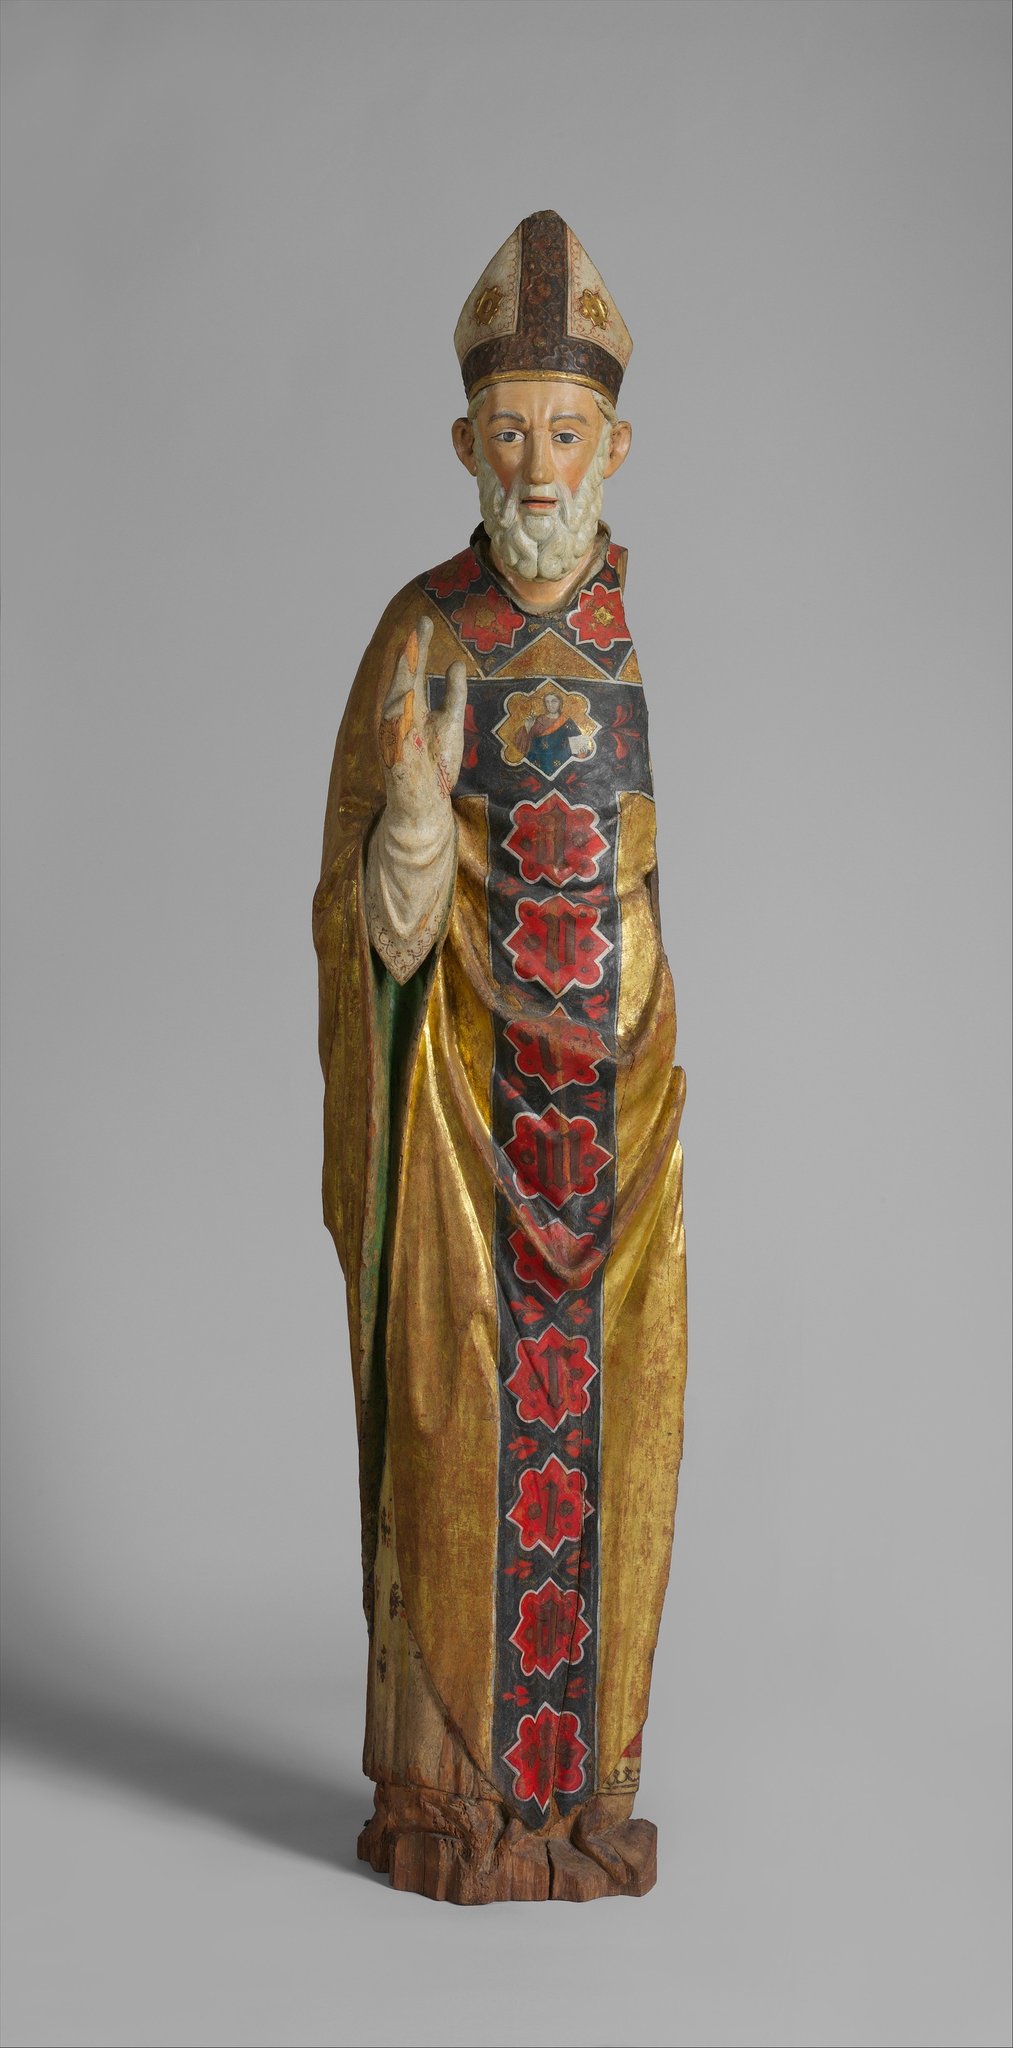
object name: relief statue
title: Blessing Bishop (Saint Nicholas of Bari)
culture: italian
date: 1350-1375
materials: paint, wood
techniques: gilding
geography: italy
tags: men,bishops